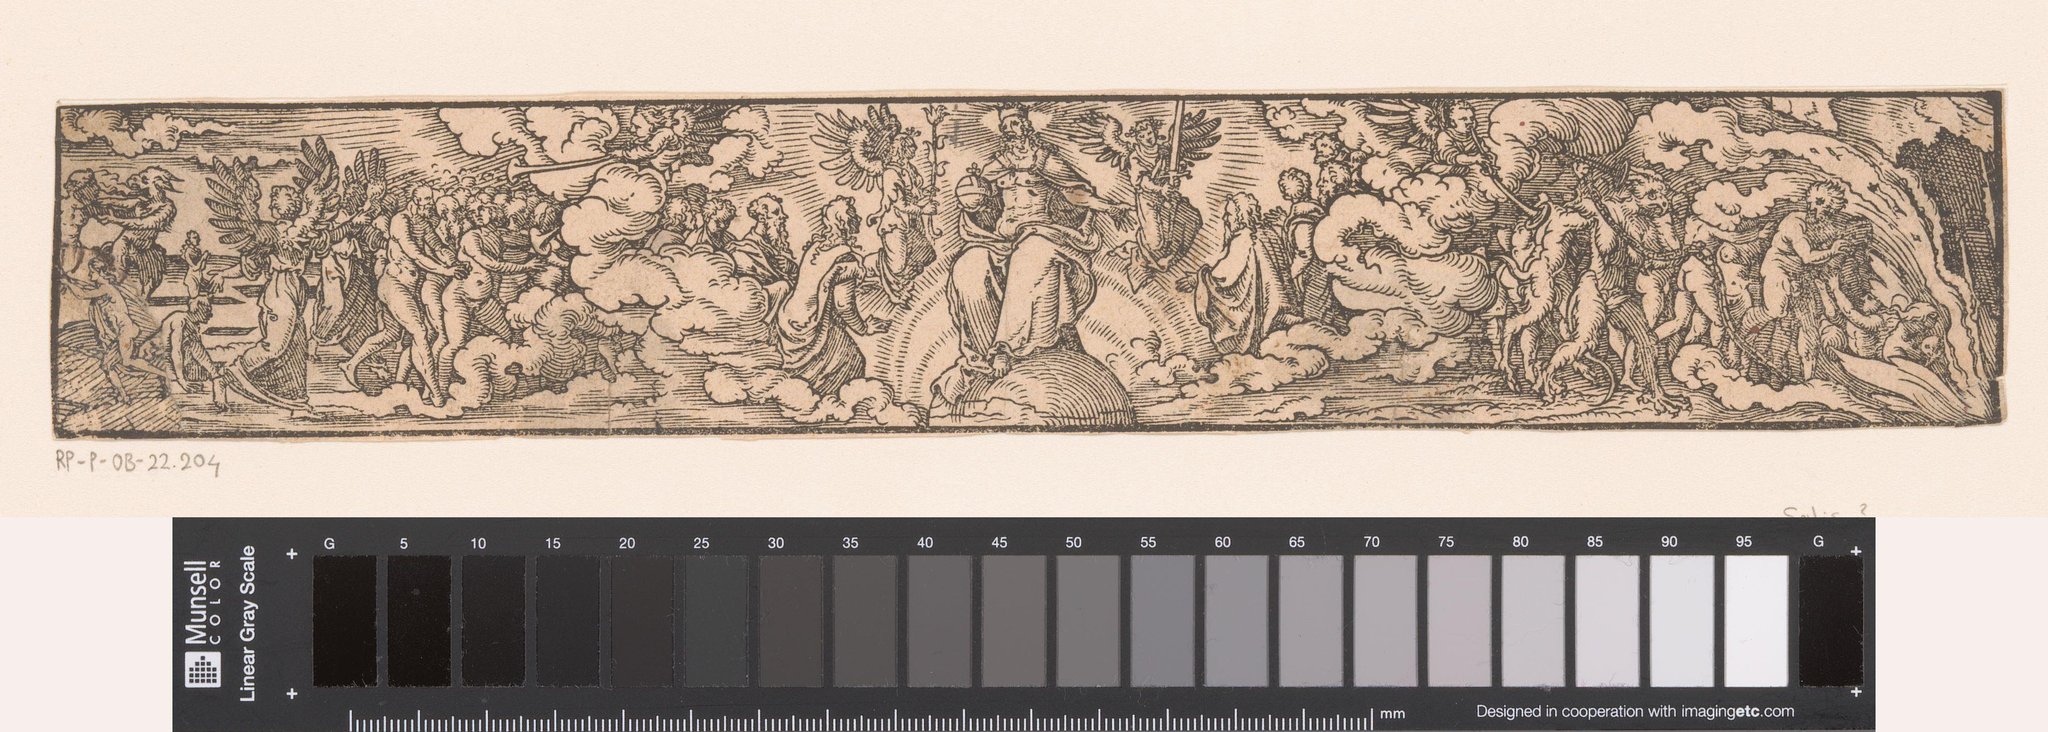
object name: print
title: Laatste Oordeel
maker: virgilius solis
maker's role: draughtsman, print maker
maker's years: 1514-1562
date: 1524-1562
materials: paper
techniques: woodcut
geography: nuremberg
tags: last judgement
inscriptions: number: ‘179’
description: De prent is linksonder beschadigd en aangevuld met een gedeelte van een onbekende andere prent met tekst in boekdruk op verso.